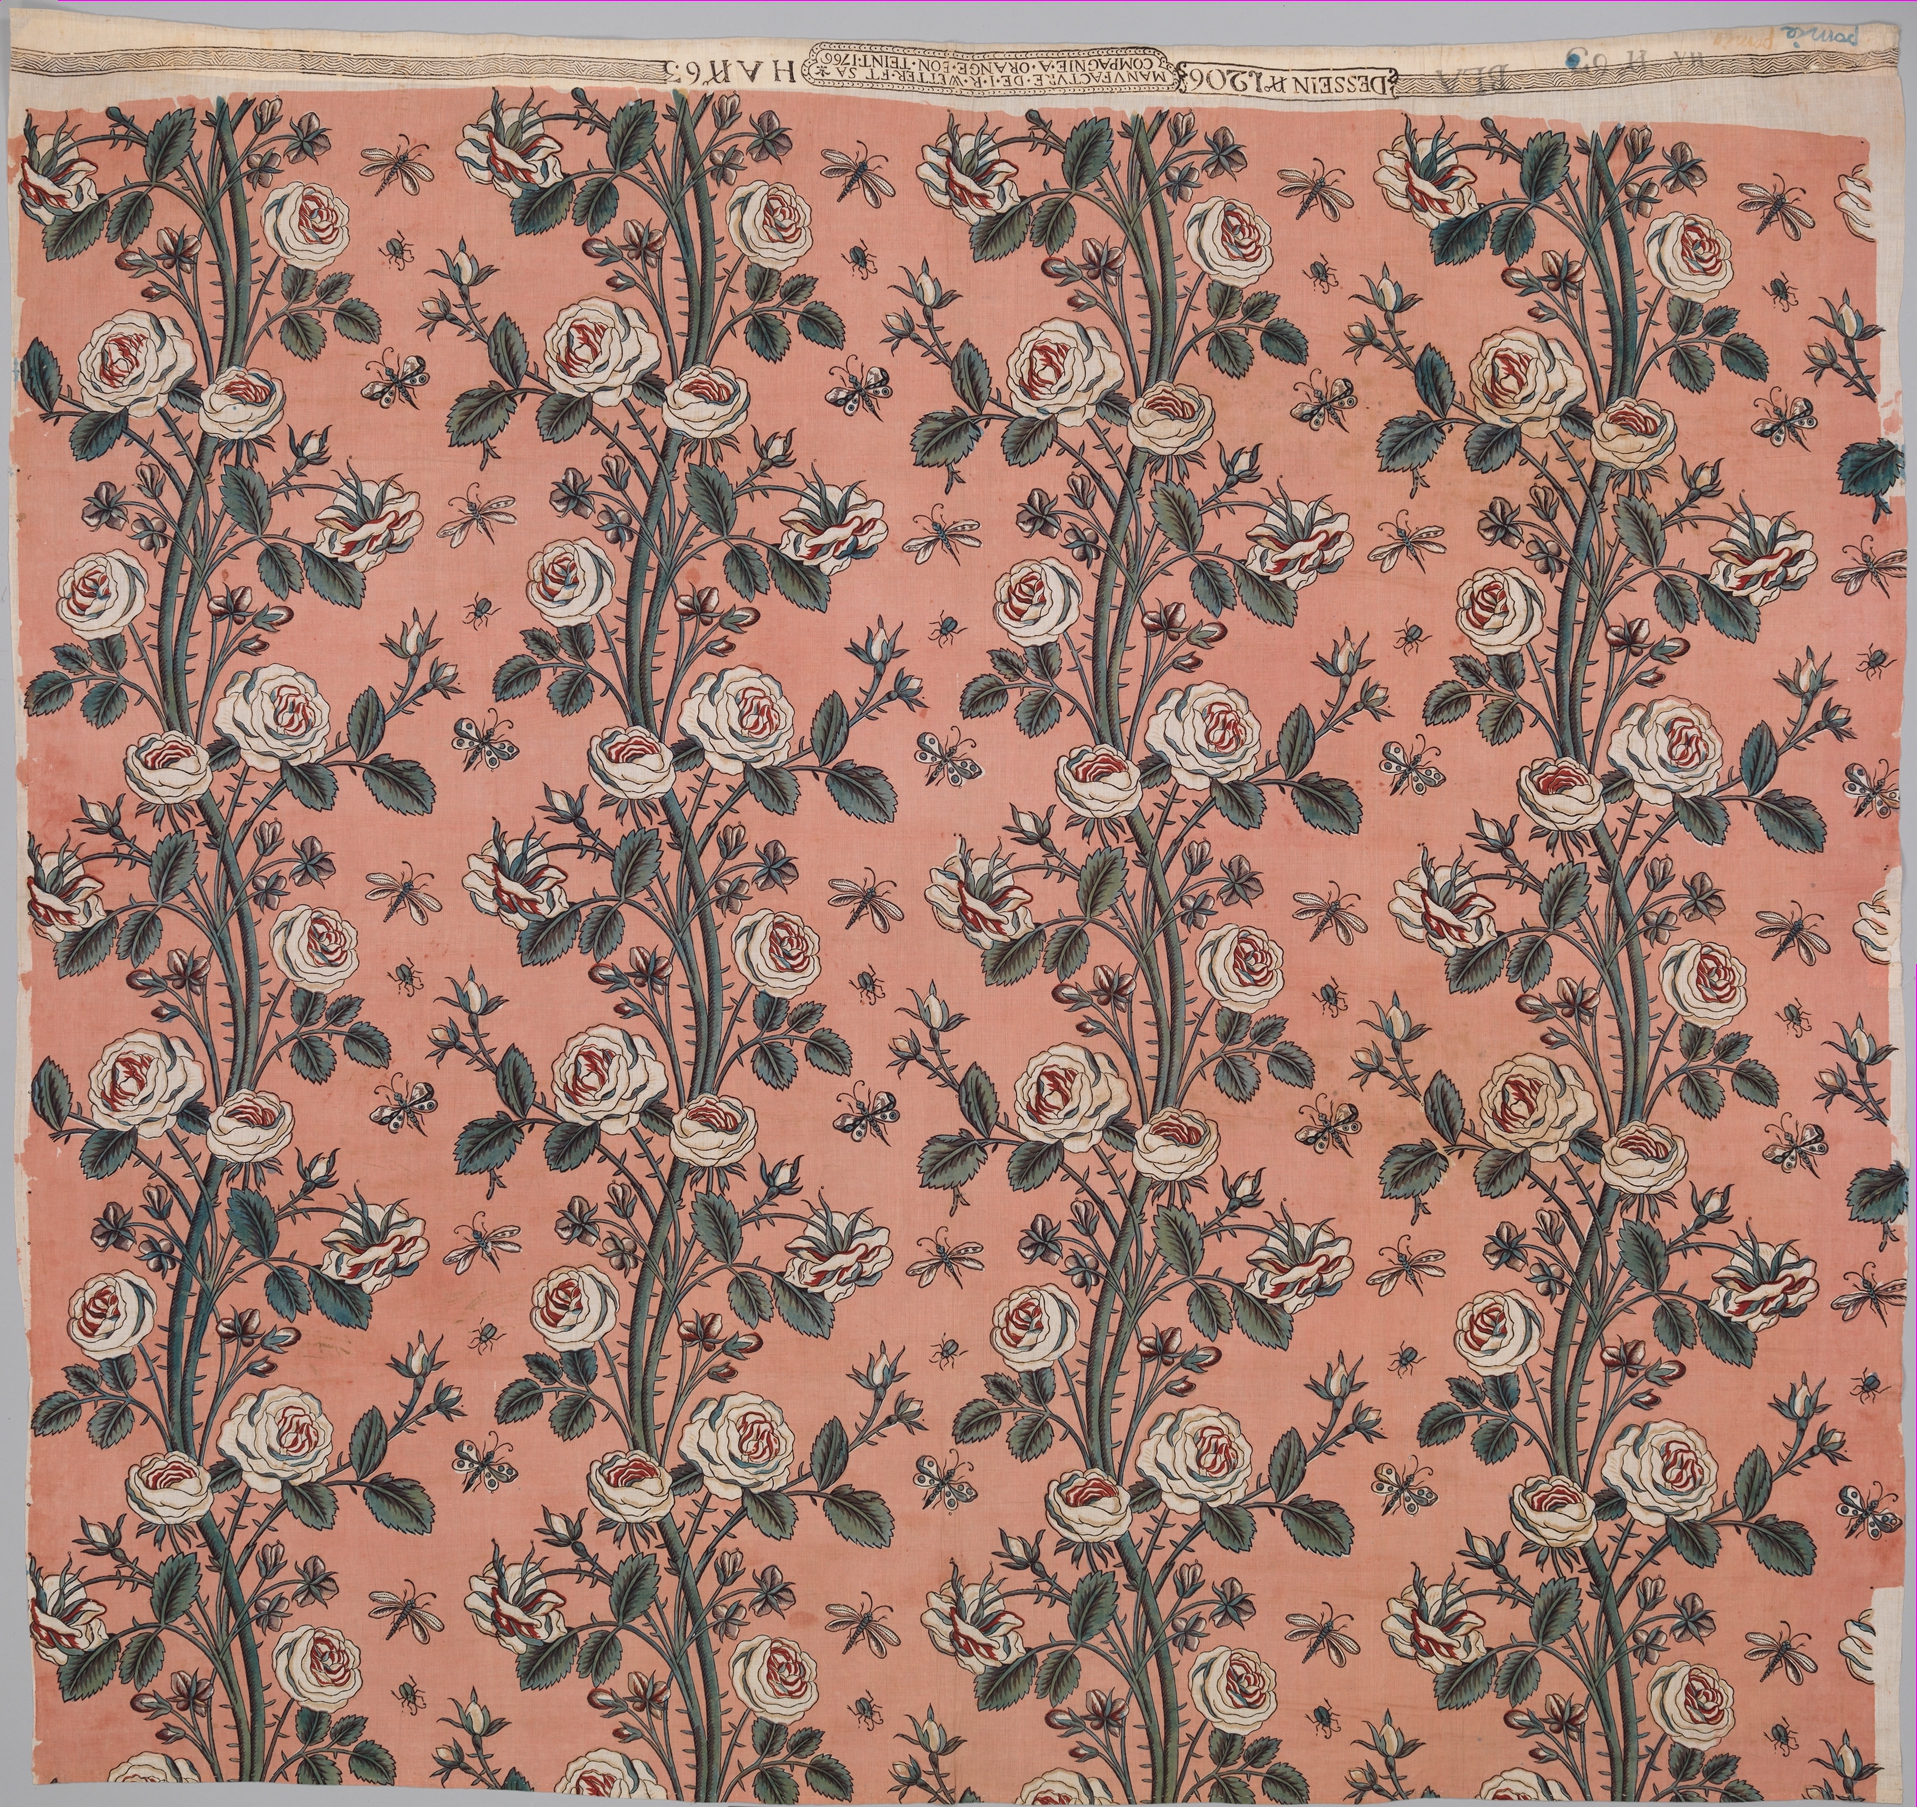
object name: floral print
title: "Climbing Roses"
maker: j.r. wetter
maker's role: manufactory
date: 1765-1775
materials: cotton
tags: roses